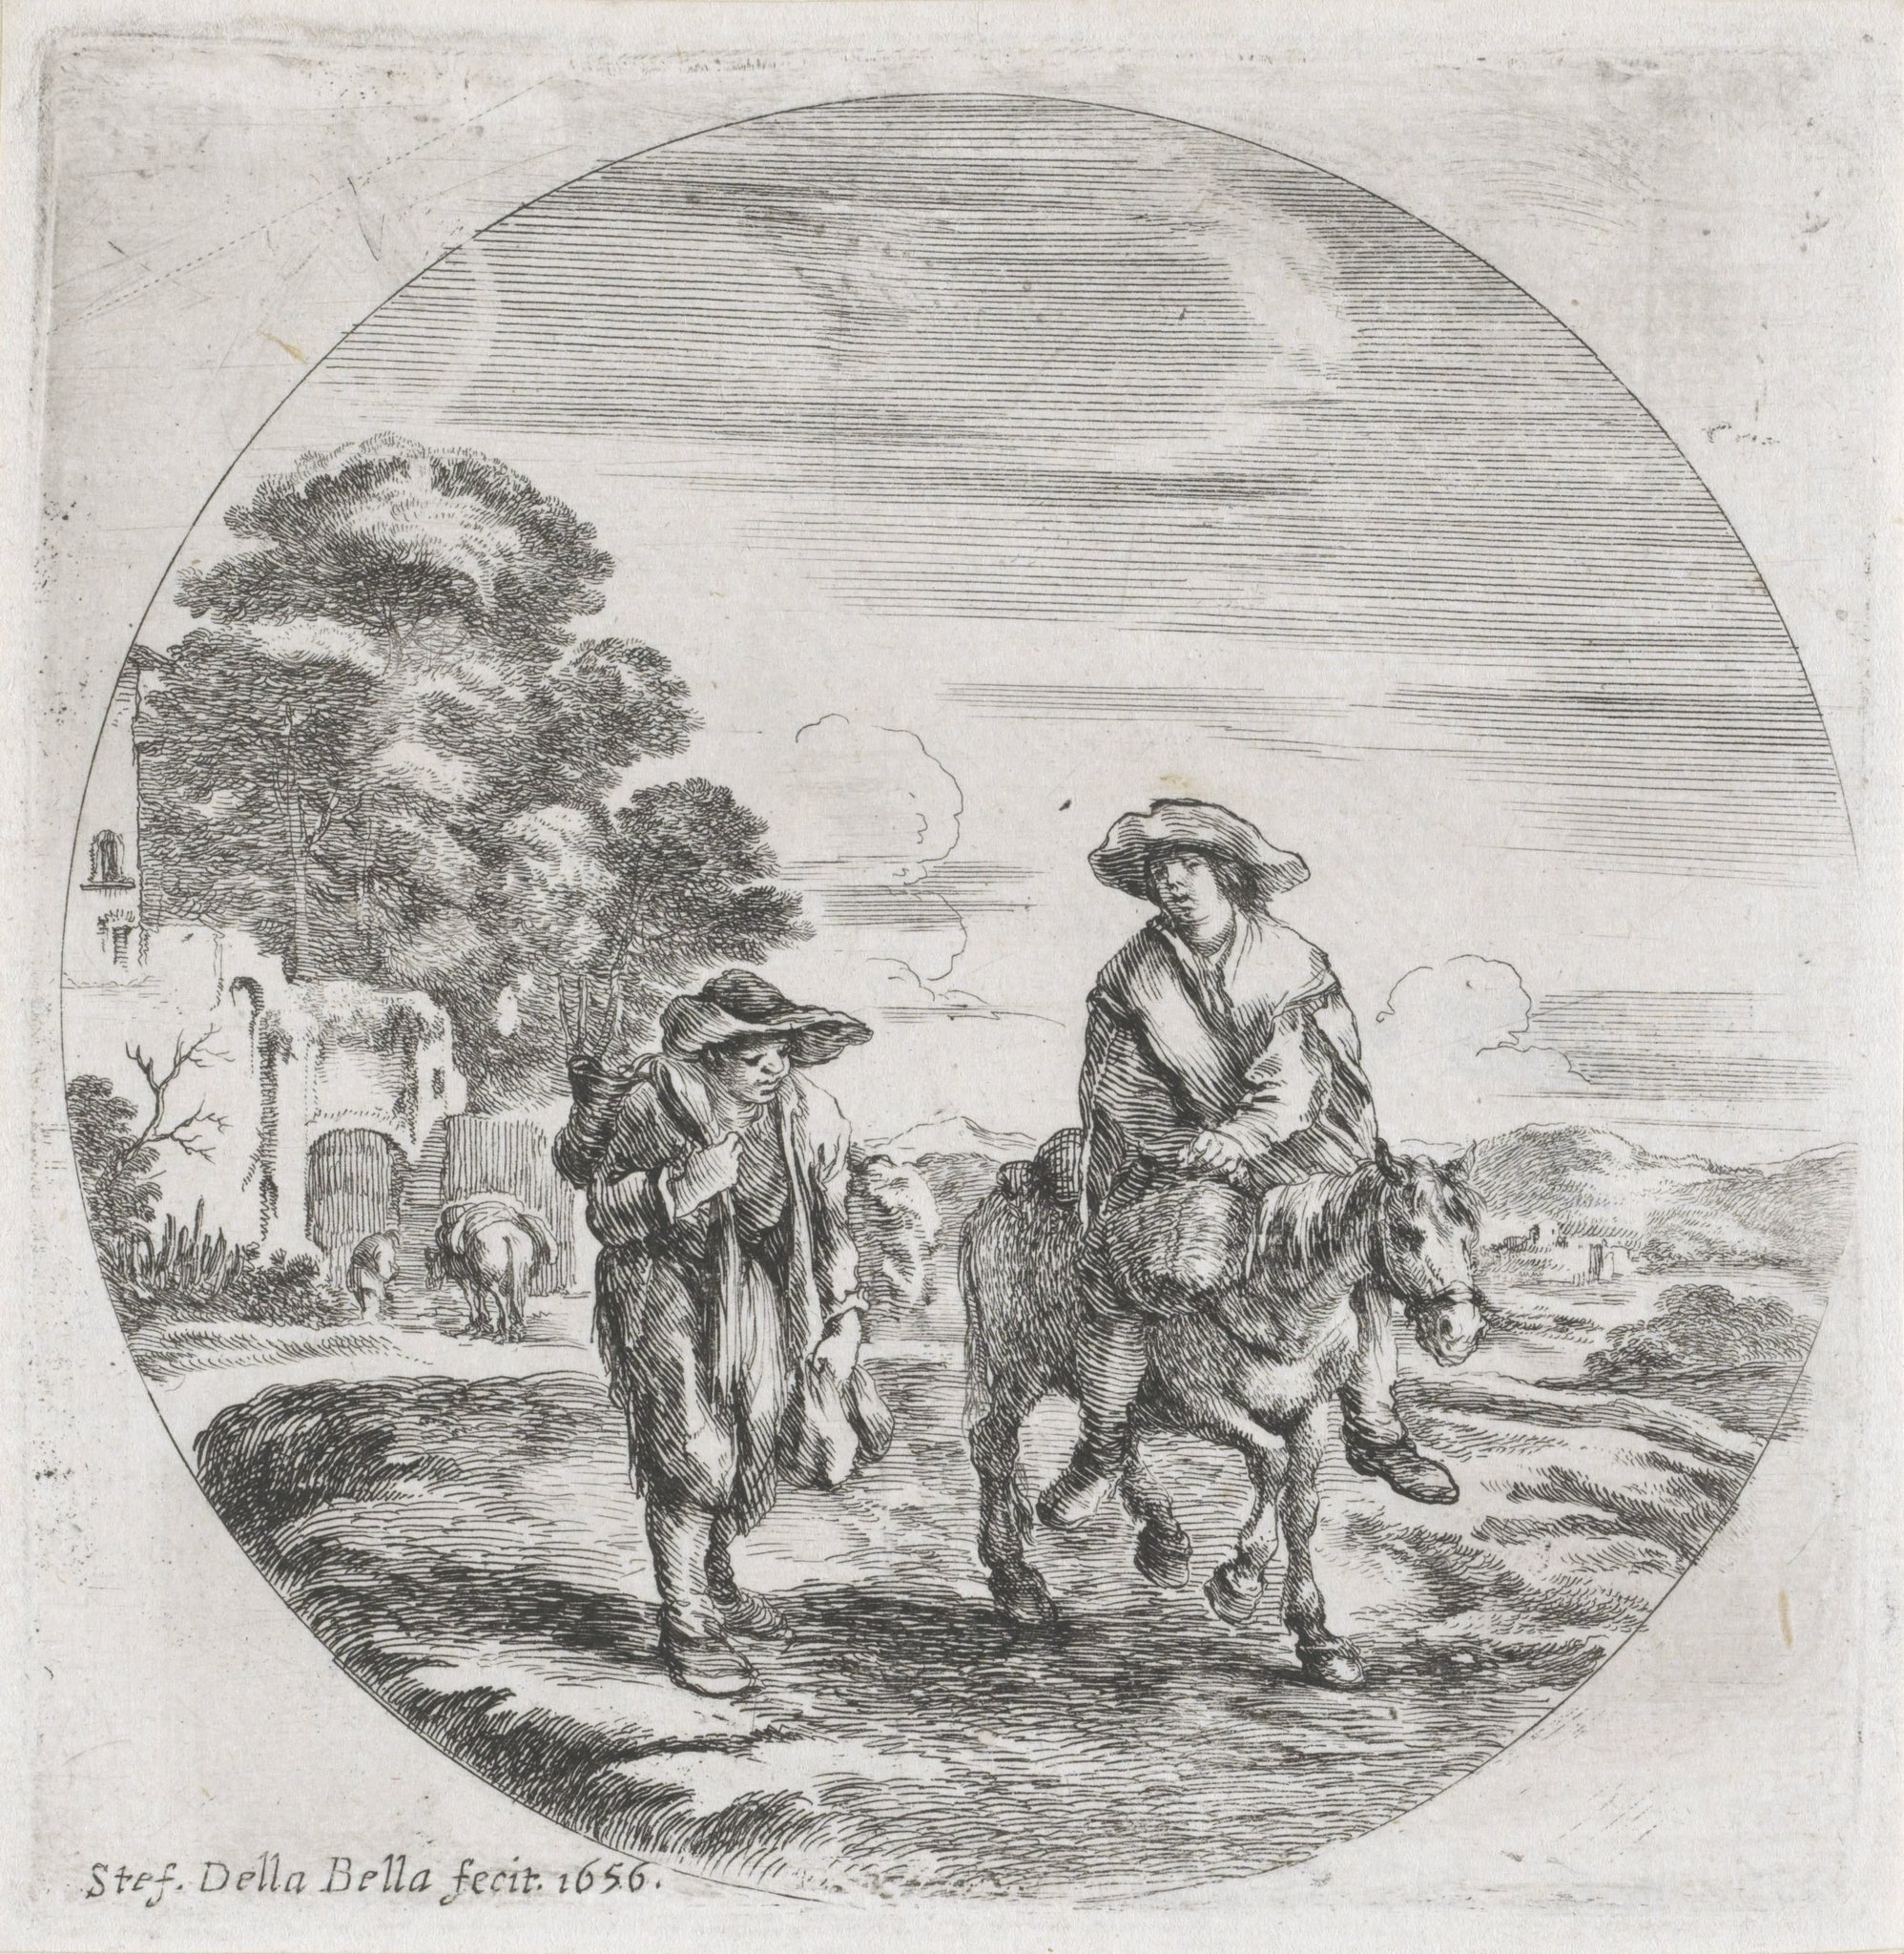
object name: print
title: Landschappen en havens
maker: stefano della bella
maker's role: draughtsman, print maker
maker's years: 1610-1664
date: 1656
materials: paper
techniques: etching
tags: riding a horse, ass, or mule; rider, horseman, farmers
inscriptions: collector's mark: Lugt 240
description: Een boer te paard en een boer te voet in een landschap. Op de achtergrond links een huis.